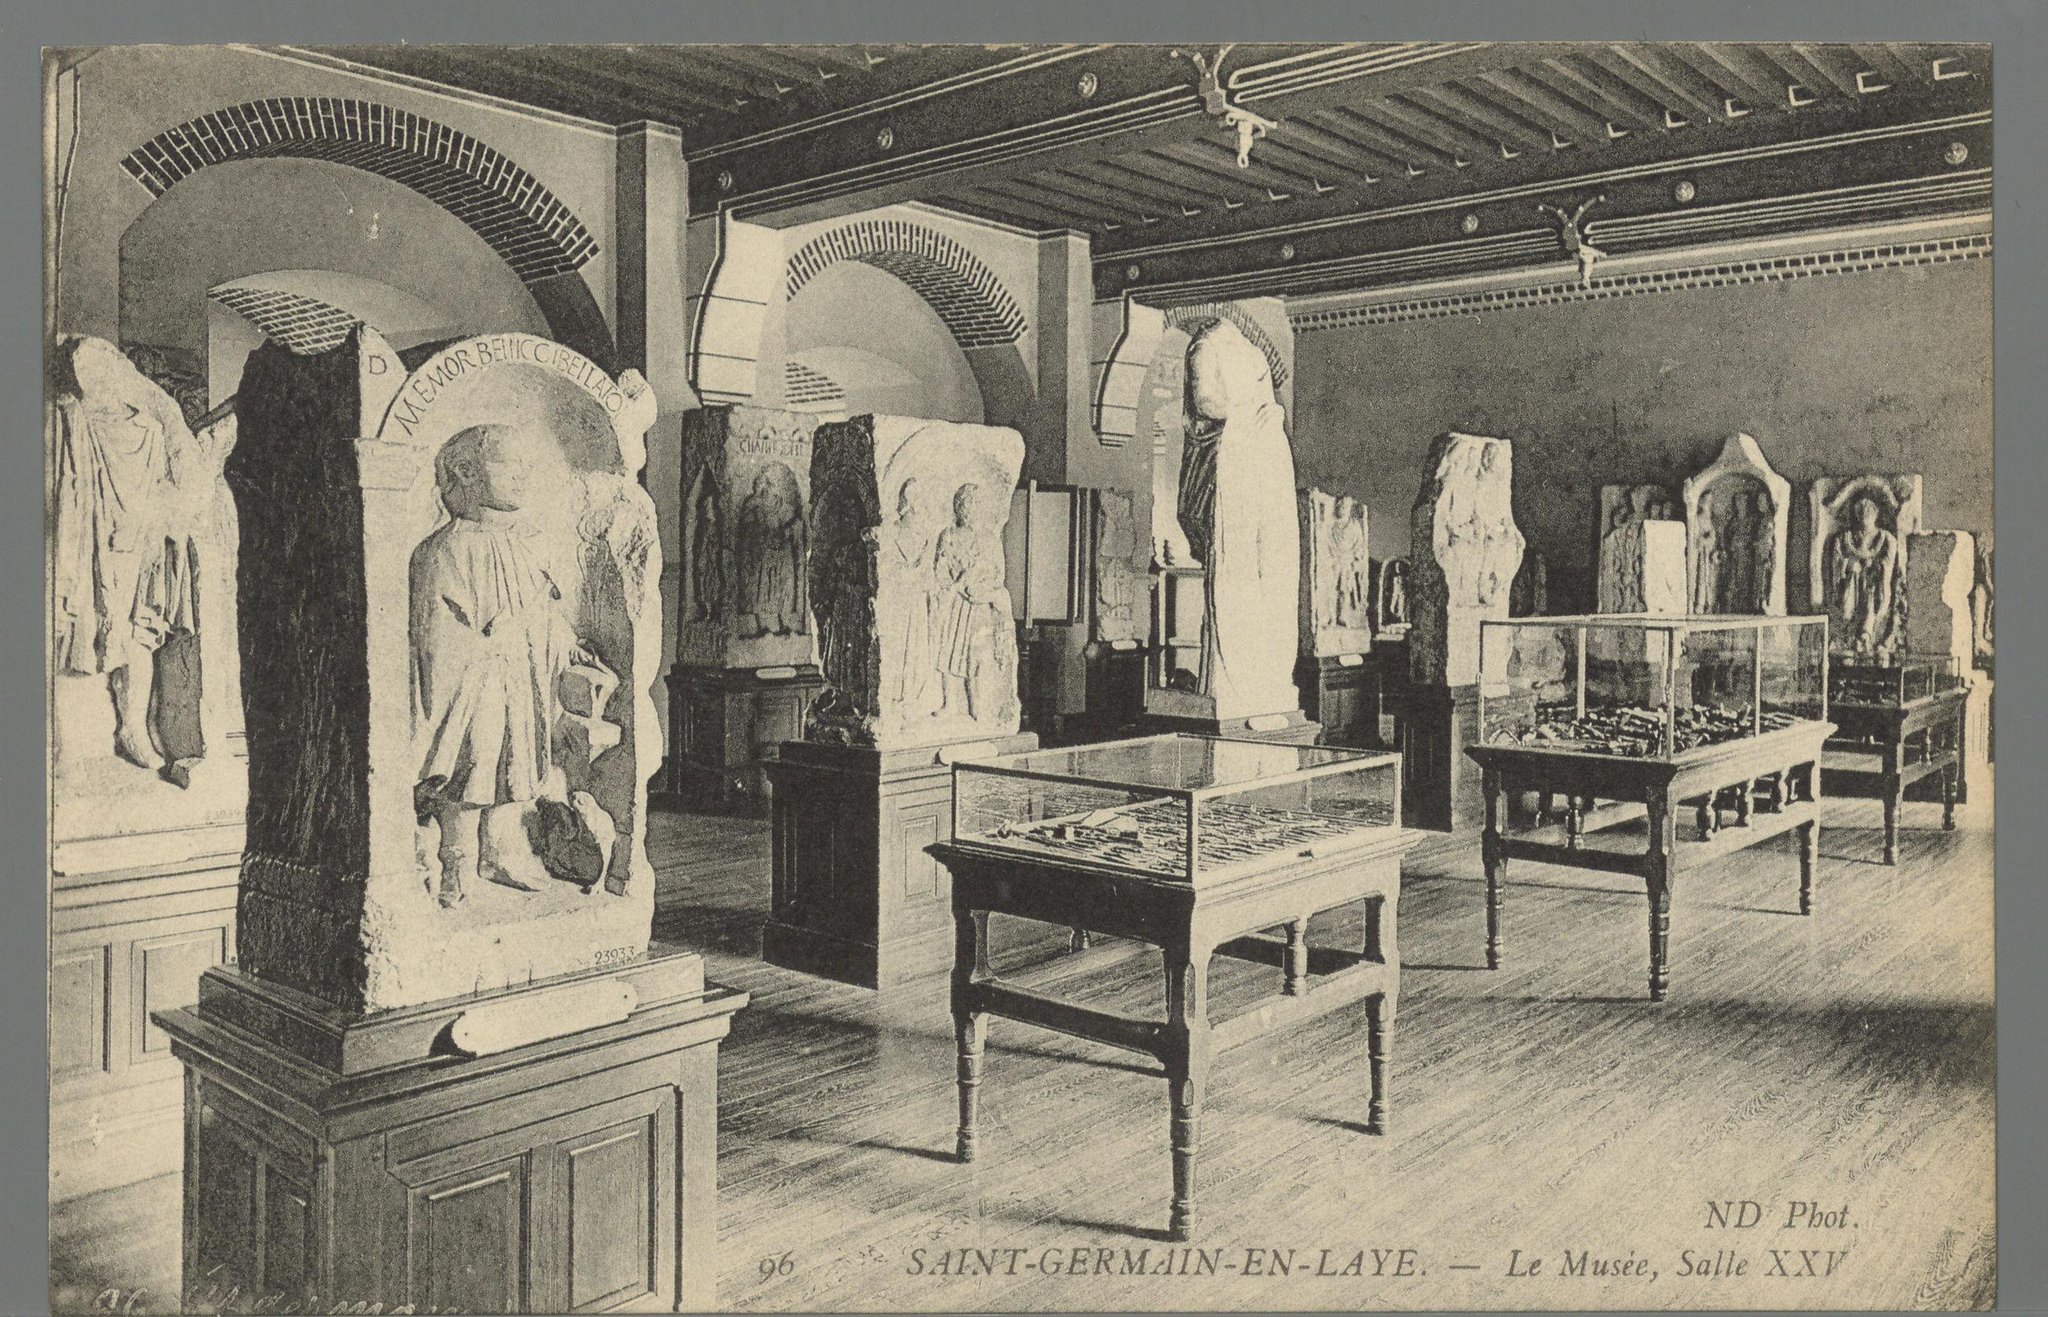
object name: photomechanical print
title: Saint-Germain-en-Laye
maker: Anonymous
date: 1904-1906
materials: cardboard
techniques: photograph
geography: paris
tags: permanent exhibition, museum, sculpture, interior ~ representation of a building